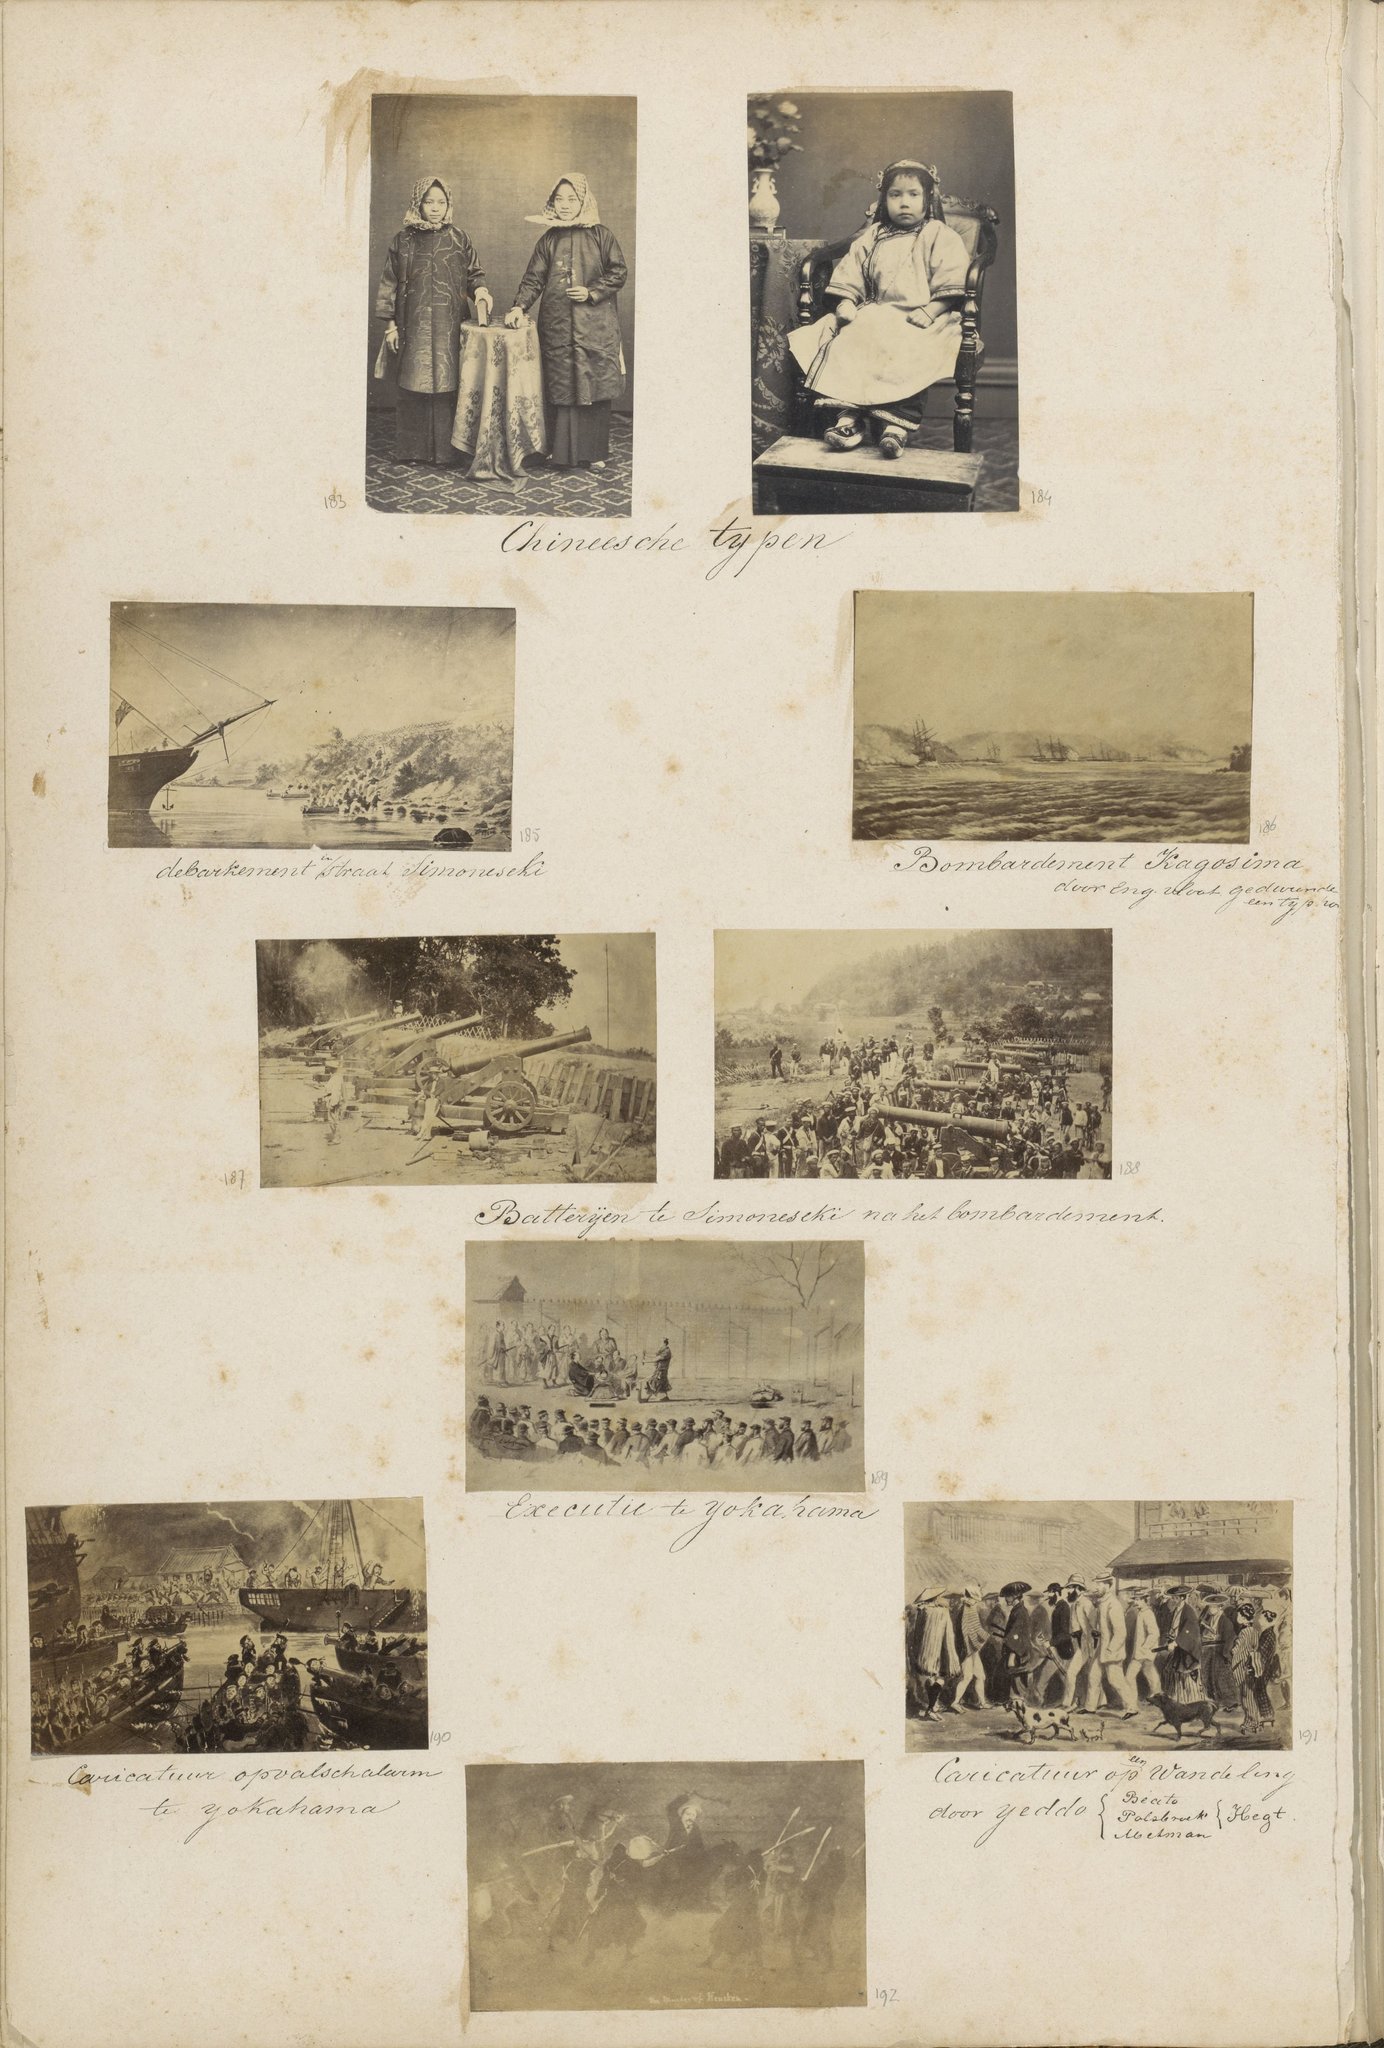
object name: photograph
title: Fotoreproductie van (vermoedelijk) een tekening van een executie in Yokohama onder het toeziend oog van westerse troepen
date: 1864-1880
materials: paper, photographic support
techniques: albumen print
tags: death penalty, execution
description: Onderdeel van Fotoalbum van Robert Daniel Crommelin (1841-1907).